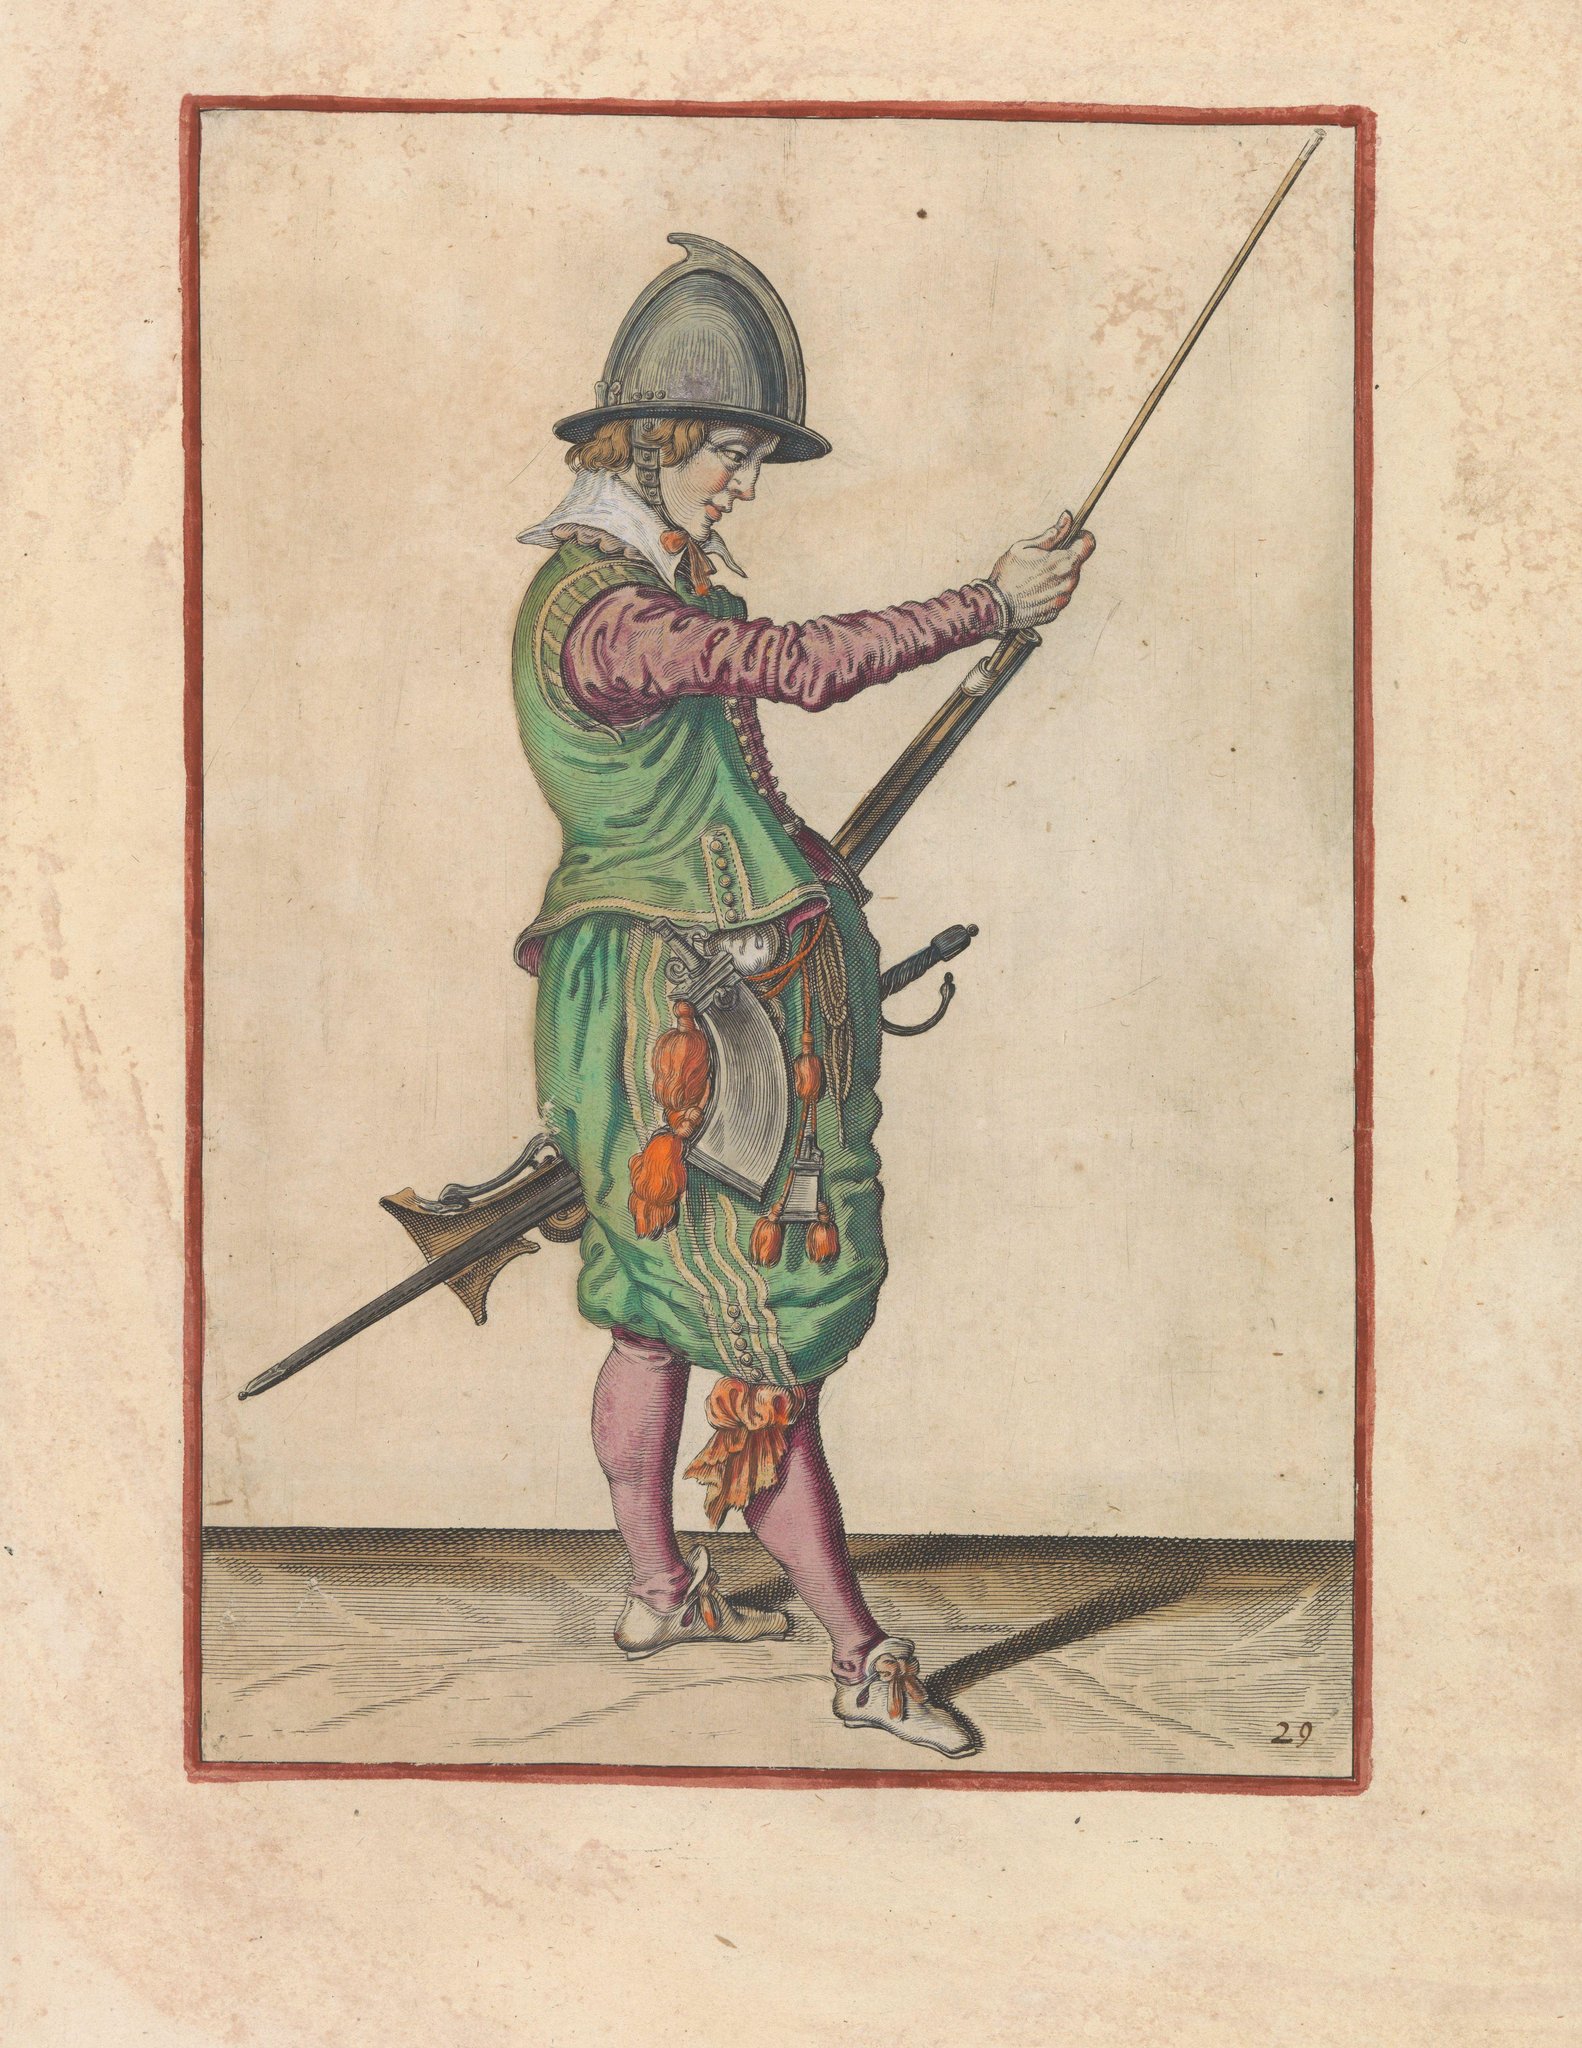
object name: print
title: Corte onderwysinghe op de figuerliicke afbeeldinghe, belanghende t'rechte ghebruyck des Roers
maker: jacques de gheyn (ii)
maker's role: painter, print maker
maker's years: 1565-1629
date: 1597-1607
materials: paper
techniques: engraving, hand coloring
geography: the hague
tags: handling of weapons ~ military training, firearms: rifle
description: Een soldaat, ten voeten uit, naar rechts, die met zijn linkerhand bij zijn linkerdijbeen een roer (een bepaald type vuurwapen) vasthoudt en met zijn rechterhand de laadstok in de houder onder de loop schuift. Deze prent is onderdeel van de reeks van 42 met de hand genummerde prenten van roerschutters in de Wapenhandelinghe.